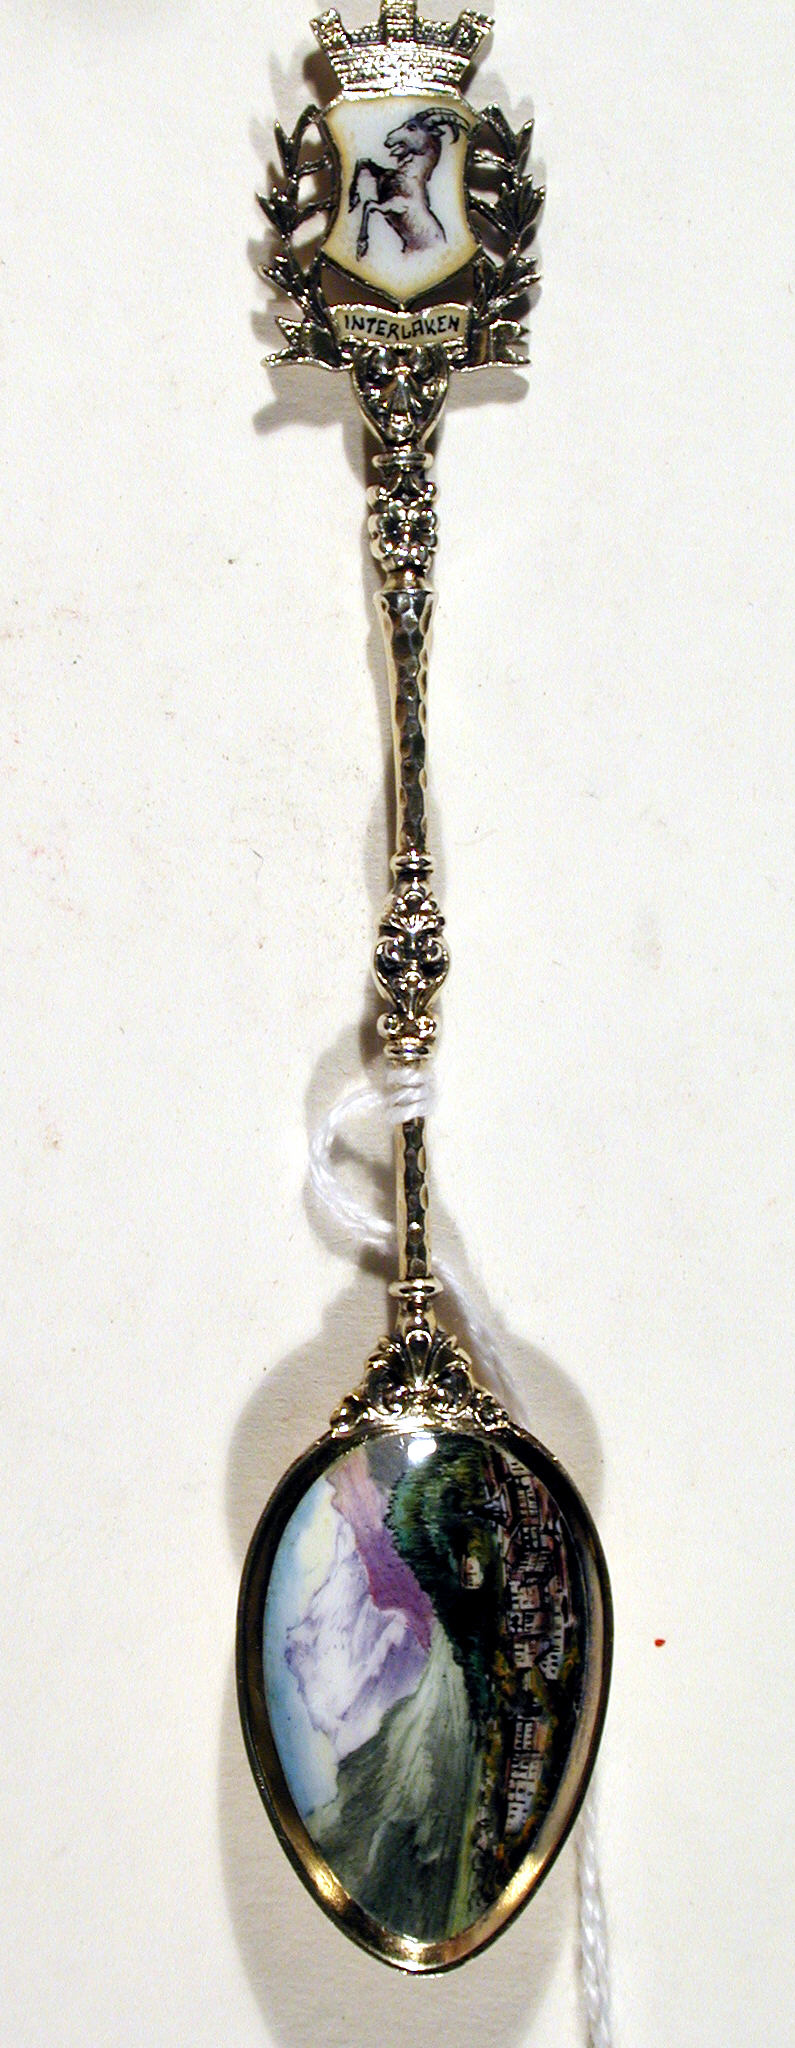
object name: souvenir spoon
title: Souvenir spoon with view of town (Interlaken?) surrounded by mountains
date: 1867-1900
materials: enamel, silver gilt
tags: houses,towns,mountains,coat of arms